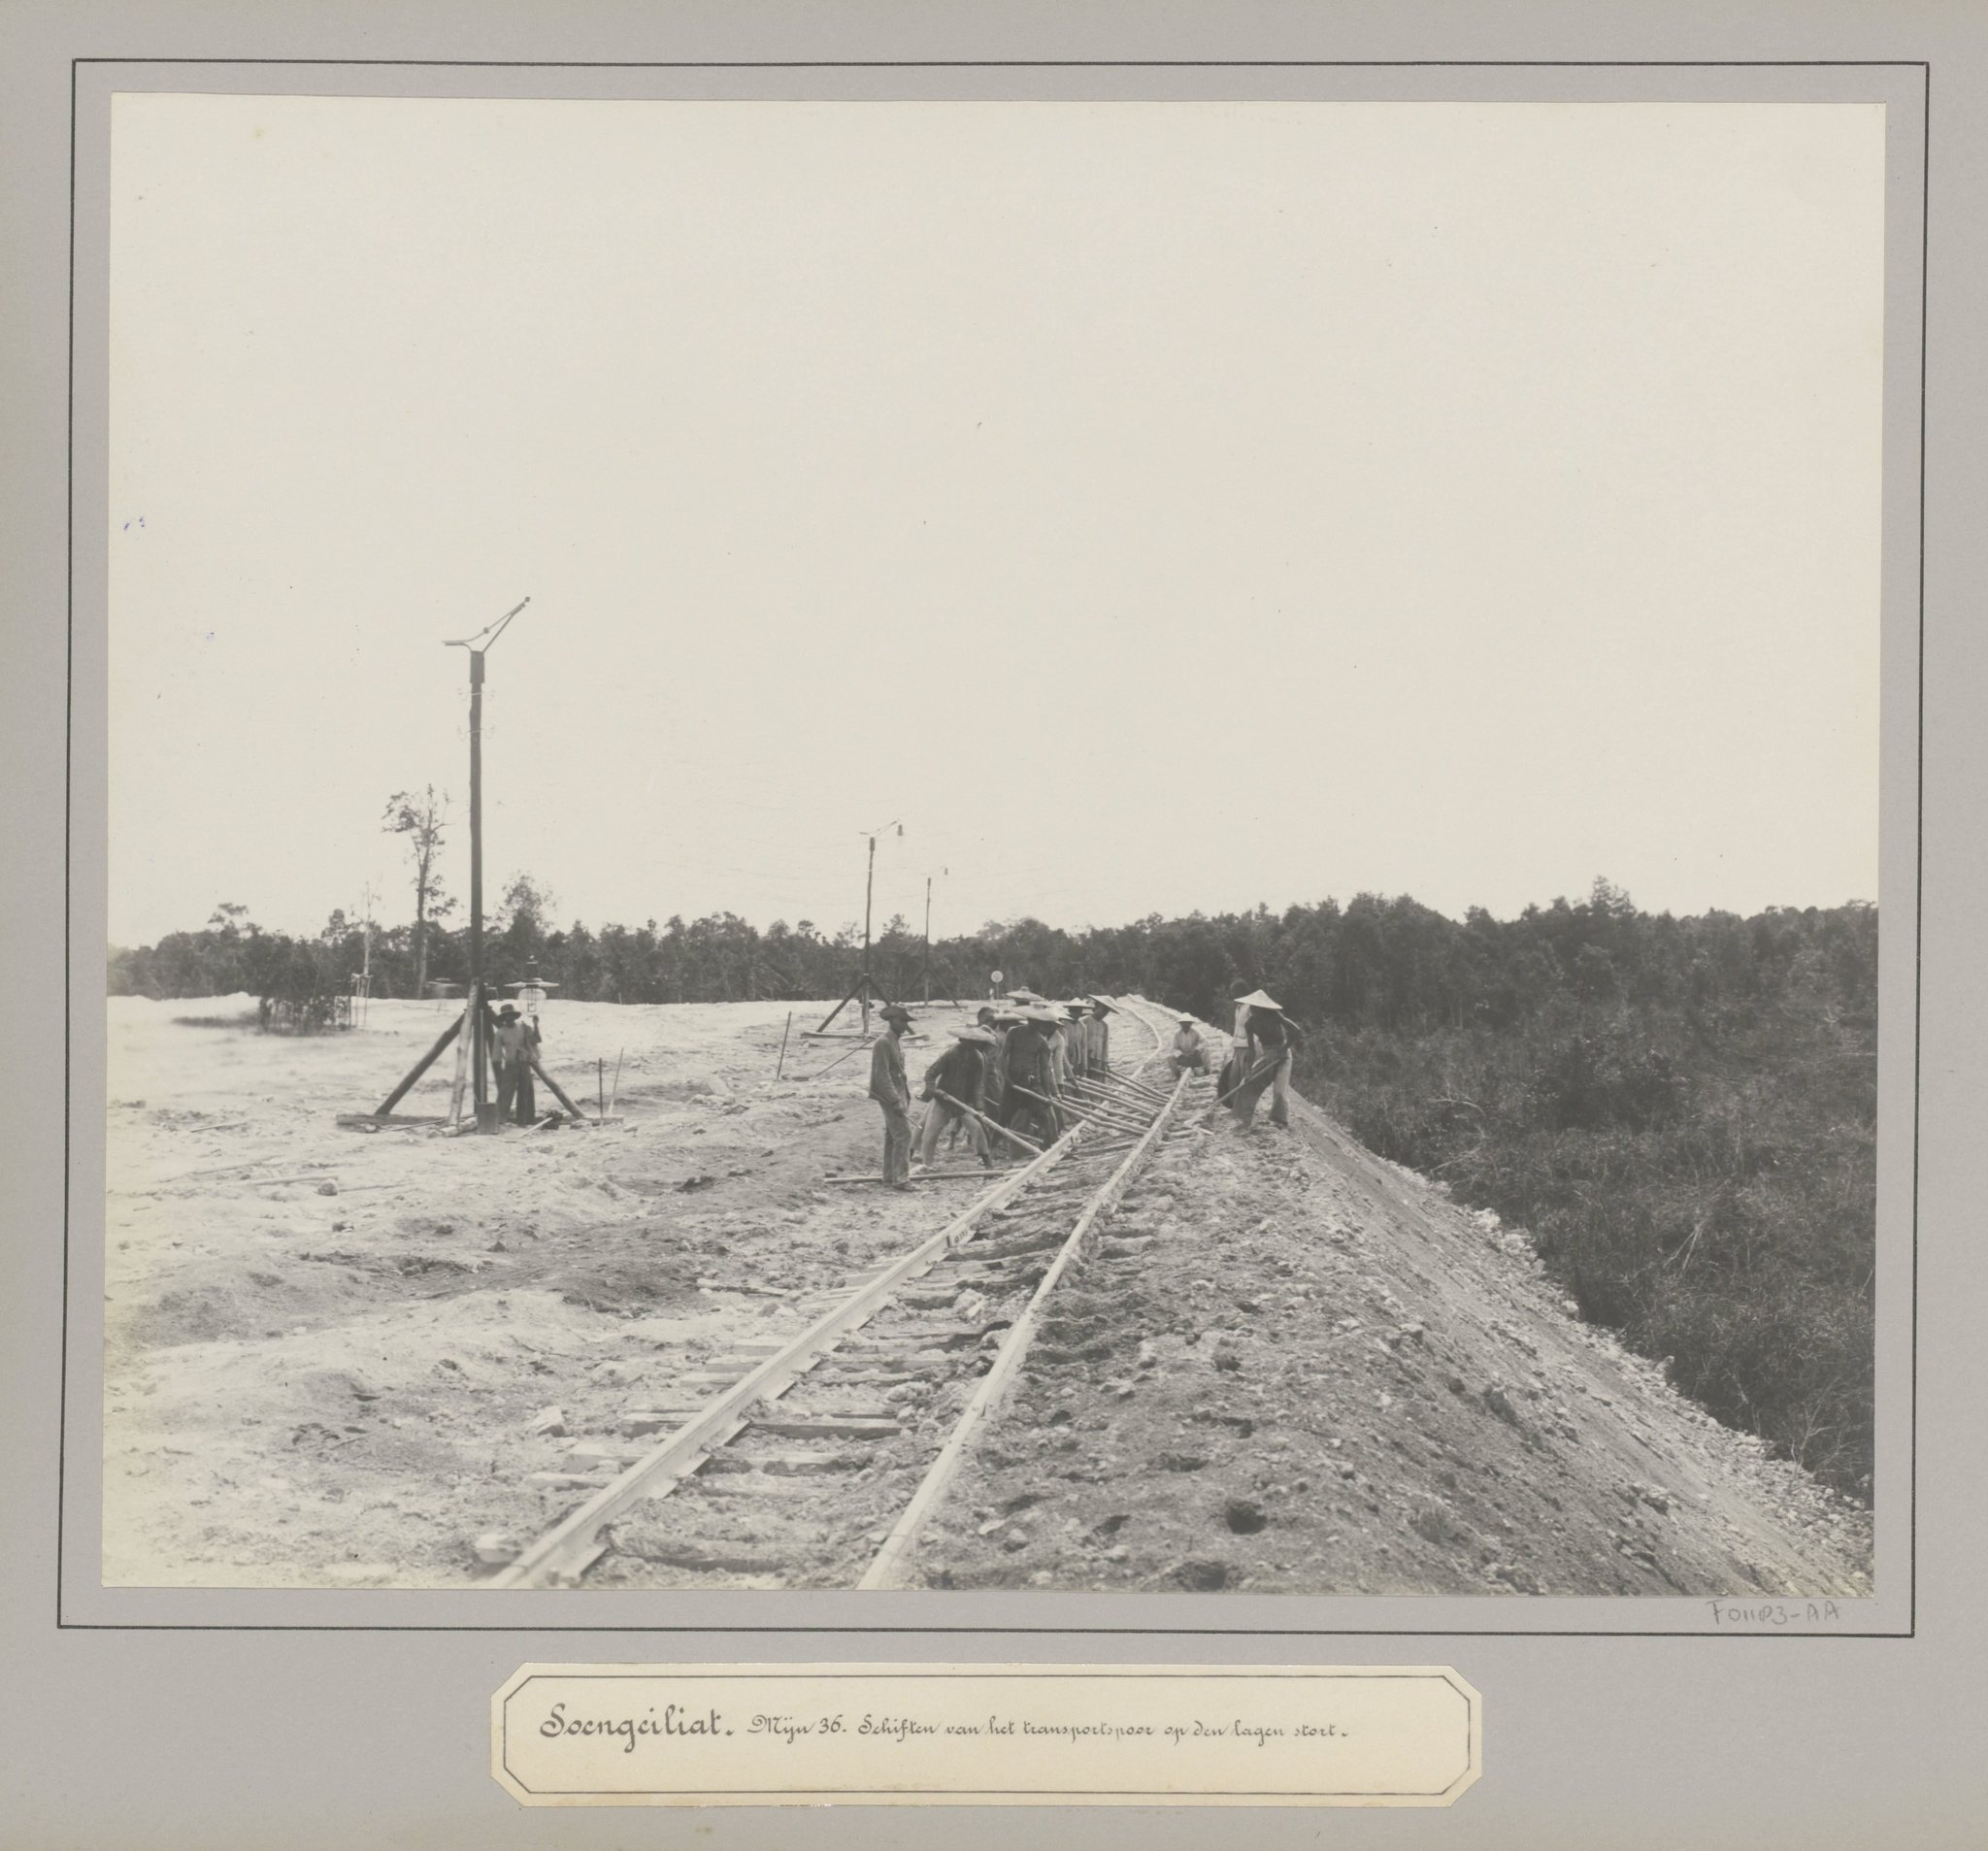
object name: photograph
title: Soengeiliat. Mijn 36. Schiften van het transportspoor op den lagen stort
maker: Anonymous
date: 1900-1920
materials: photographic support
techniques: gelatin silver print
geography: soengeiliat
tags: mining, minerals and metals: tin, working class, labourers, railway, train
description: Onderdeel van Fotoalbum over de tinwinning op Bangka.